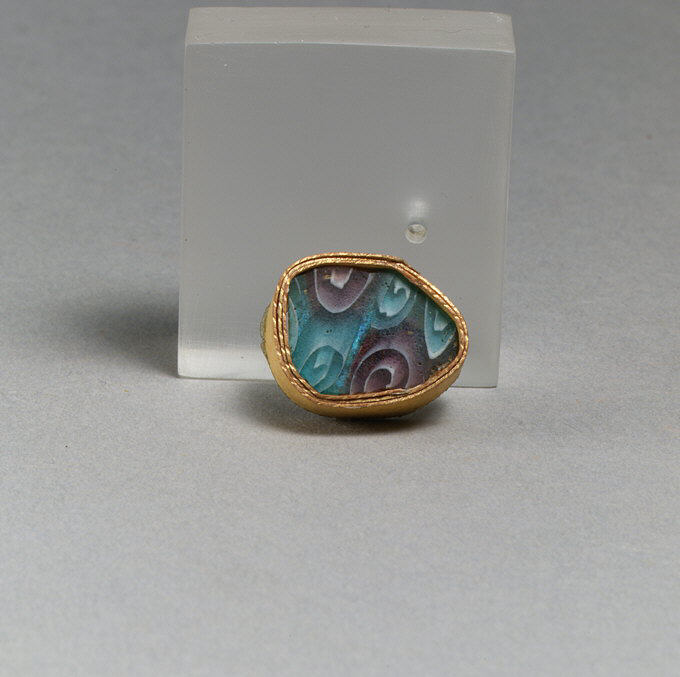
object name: fragment, mosaic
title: Glass mosaic fragment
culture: greek, eastern mediterranean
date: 200-35 BCE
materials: glass